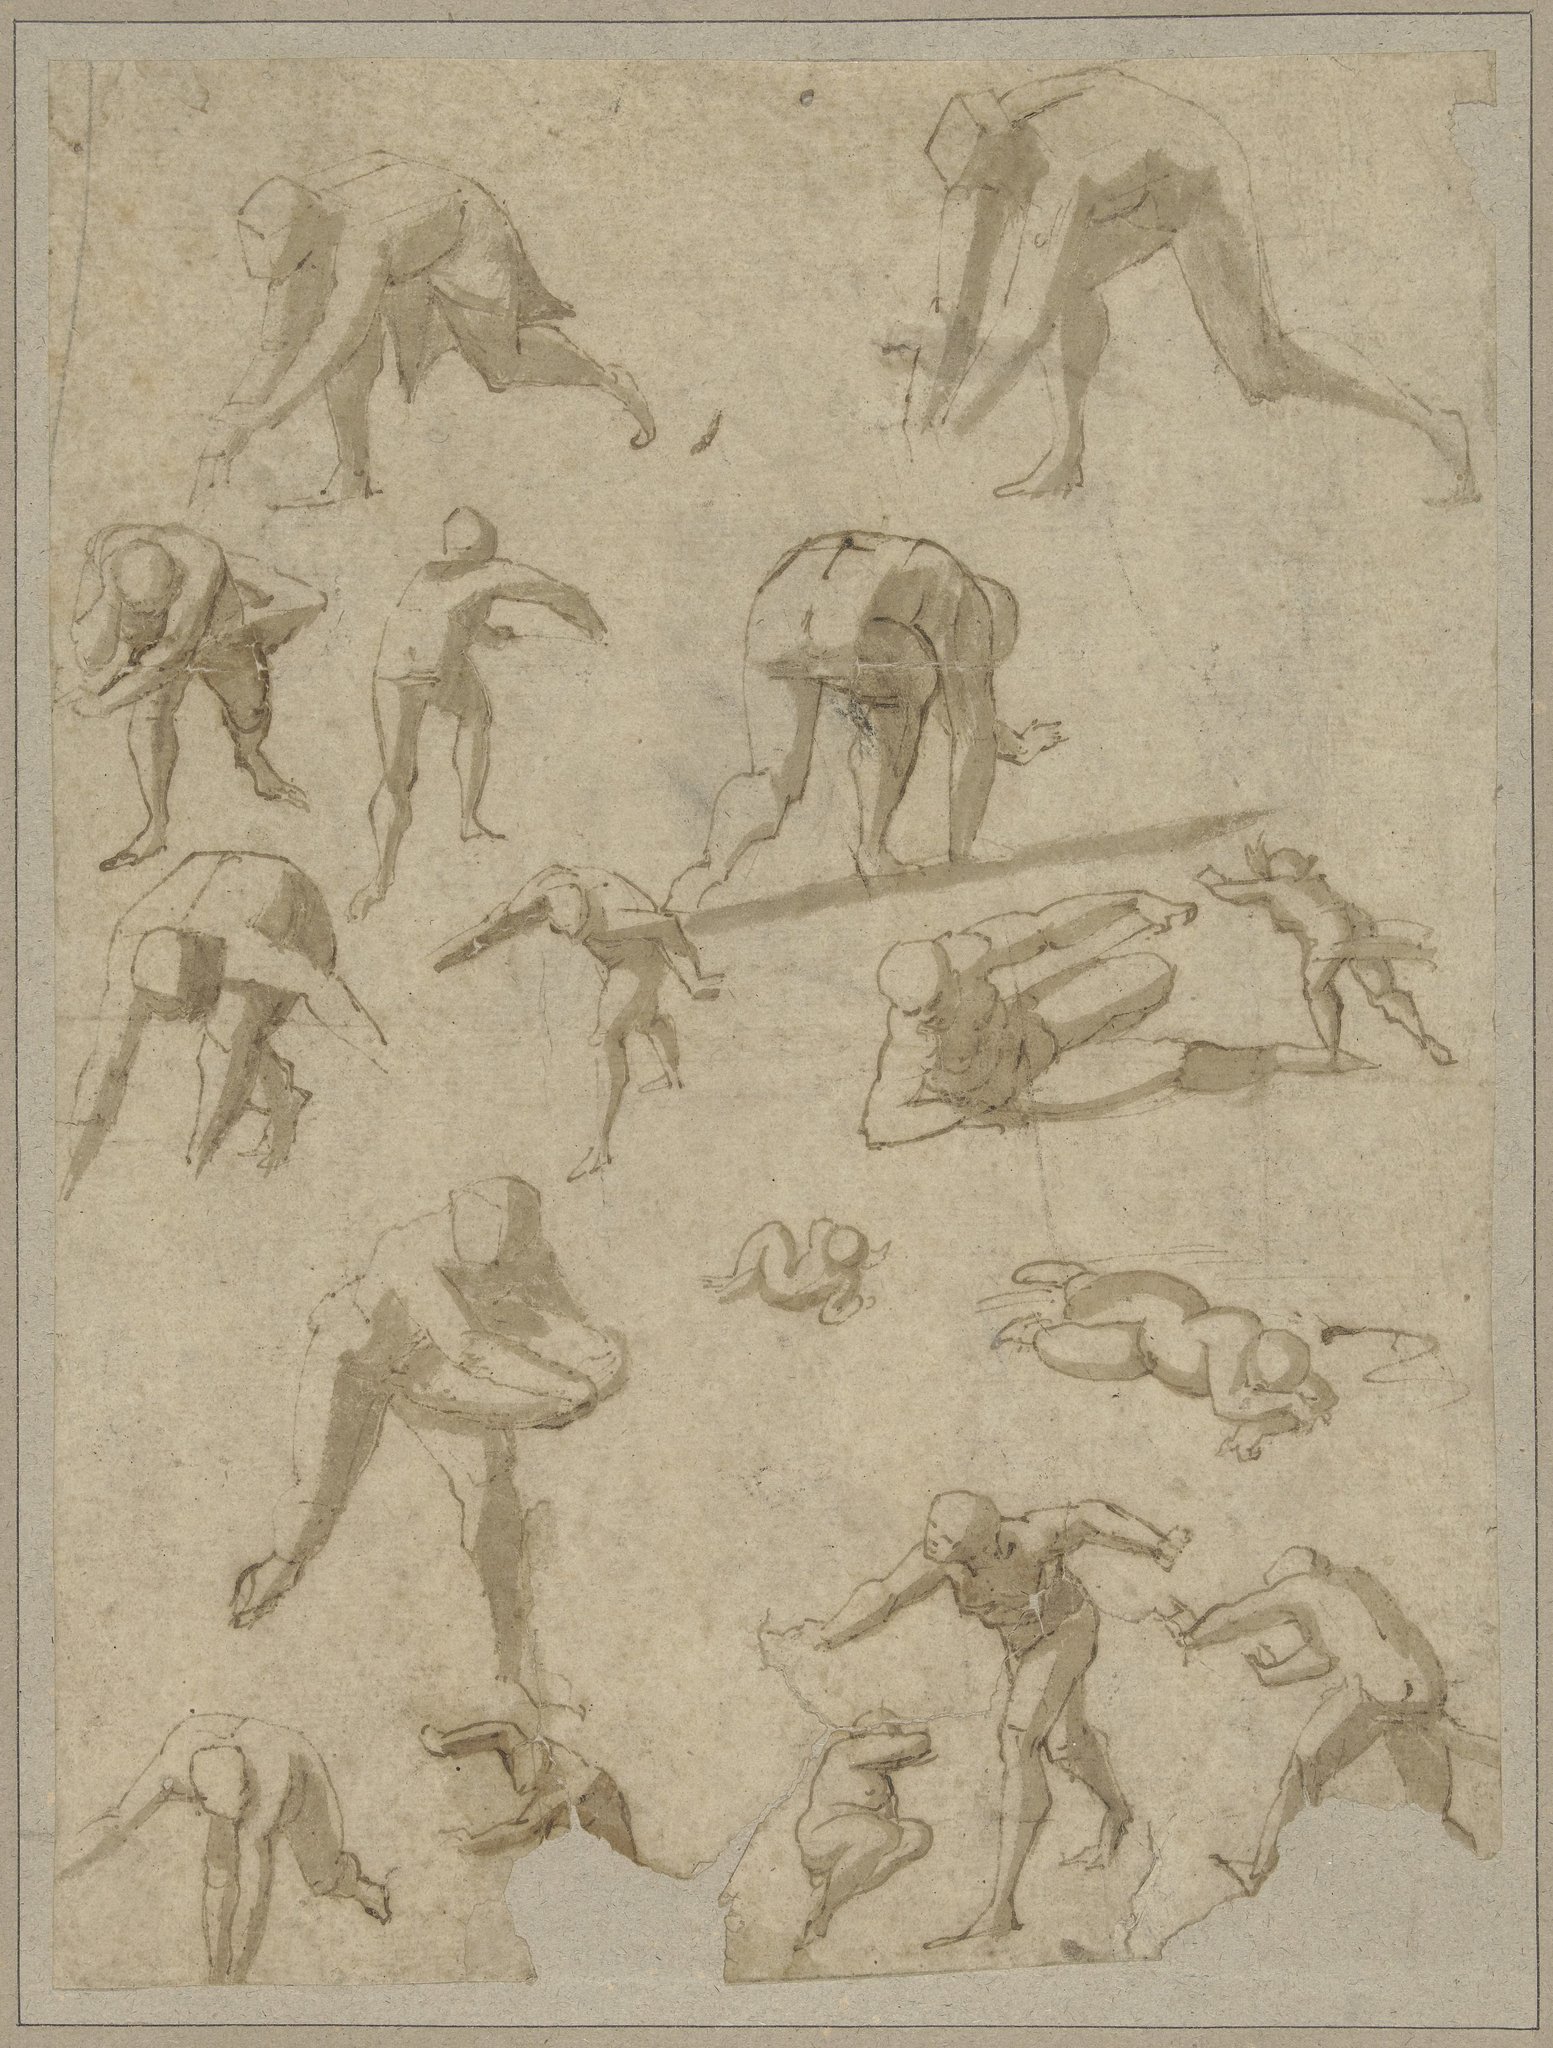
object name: drawing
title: Bewegende figuren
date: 1540-1620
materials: ink, paper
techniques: brush, pen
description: Schetsblad met bewegende figuren, kubistisch gezien.